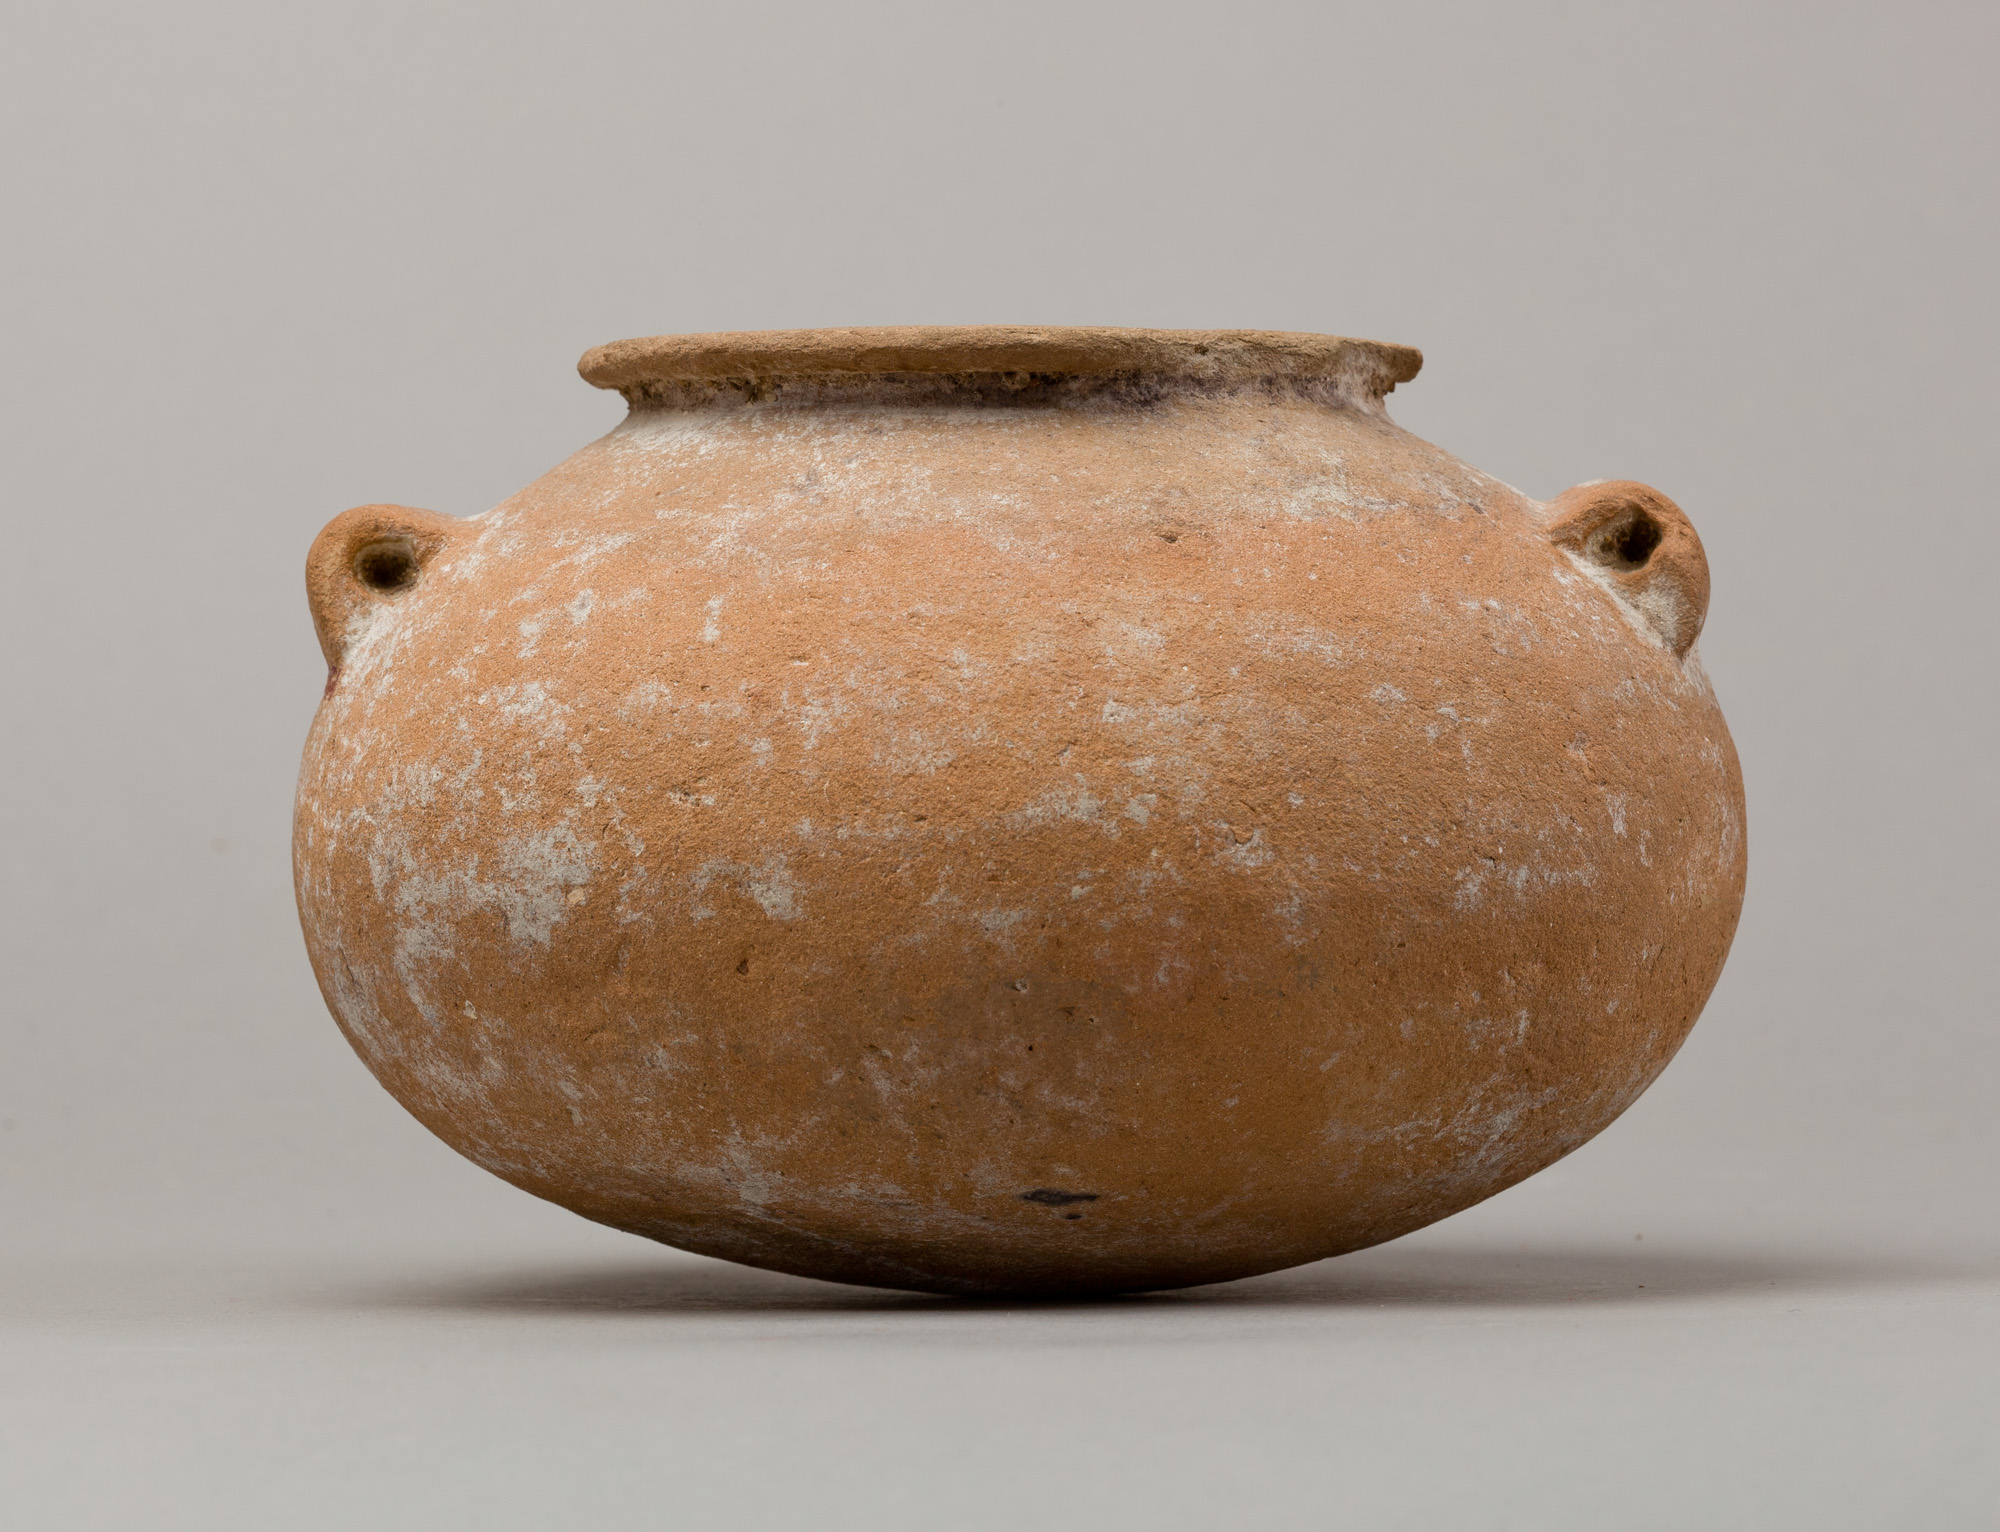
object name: jar, decorated ware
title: Marl ware jar with lug handles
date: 3850-2960 BCE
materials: pottery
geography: egypt